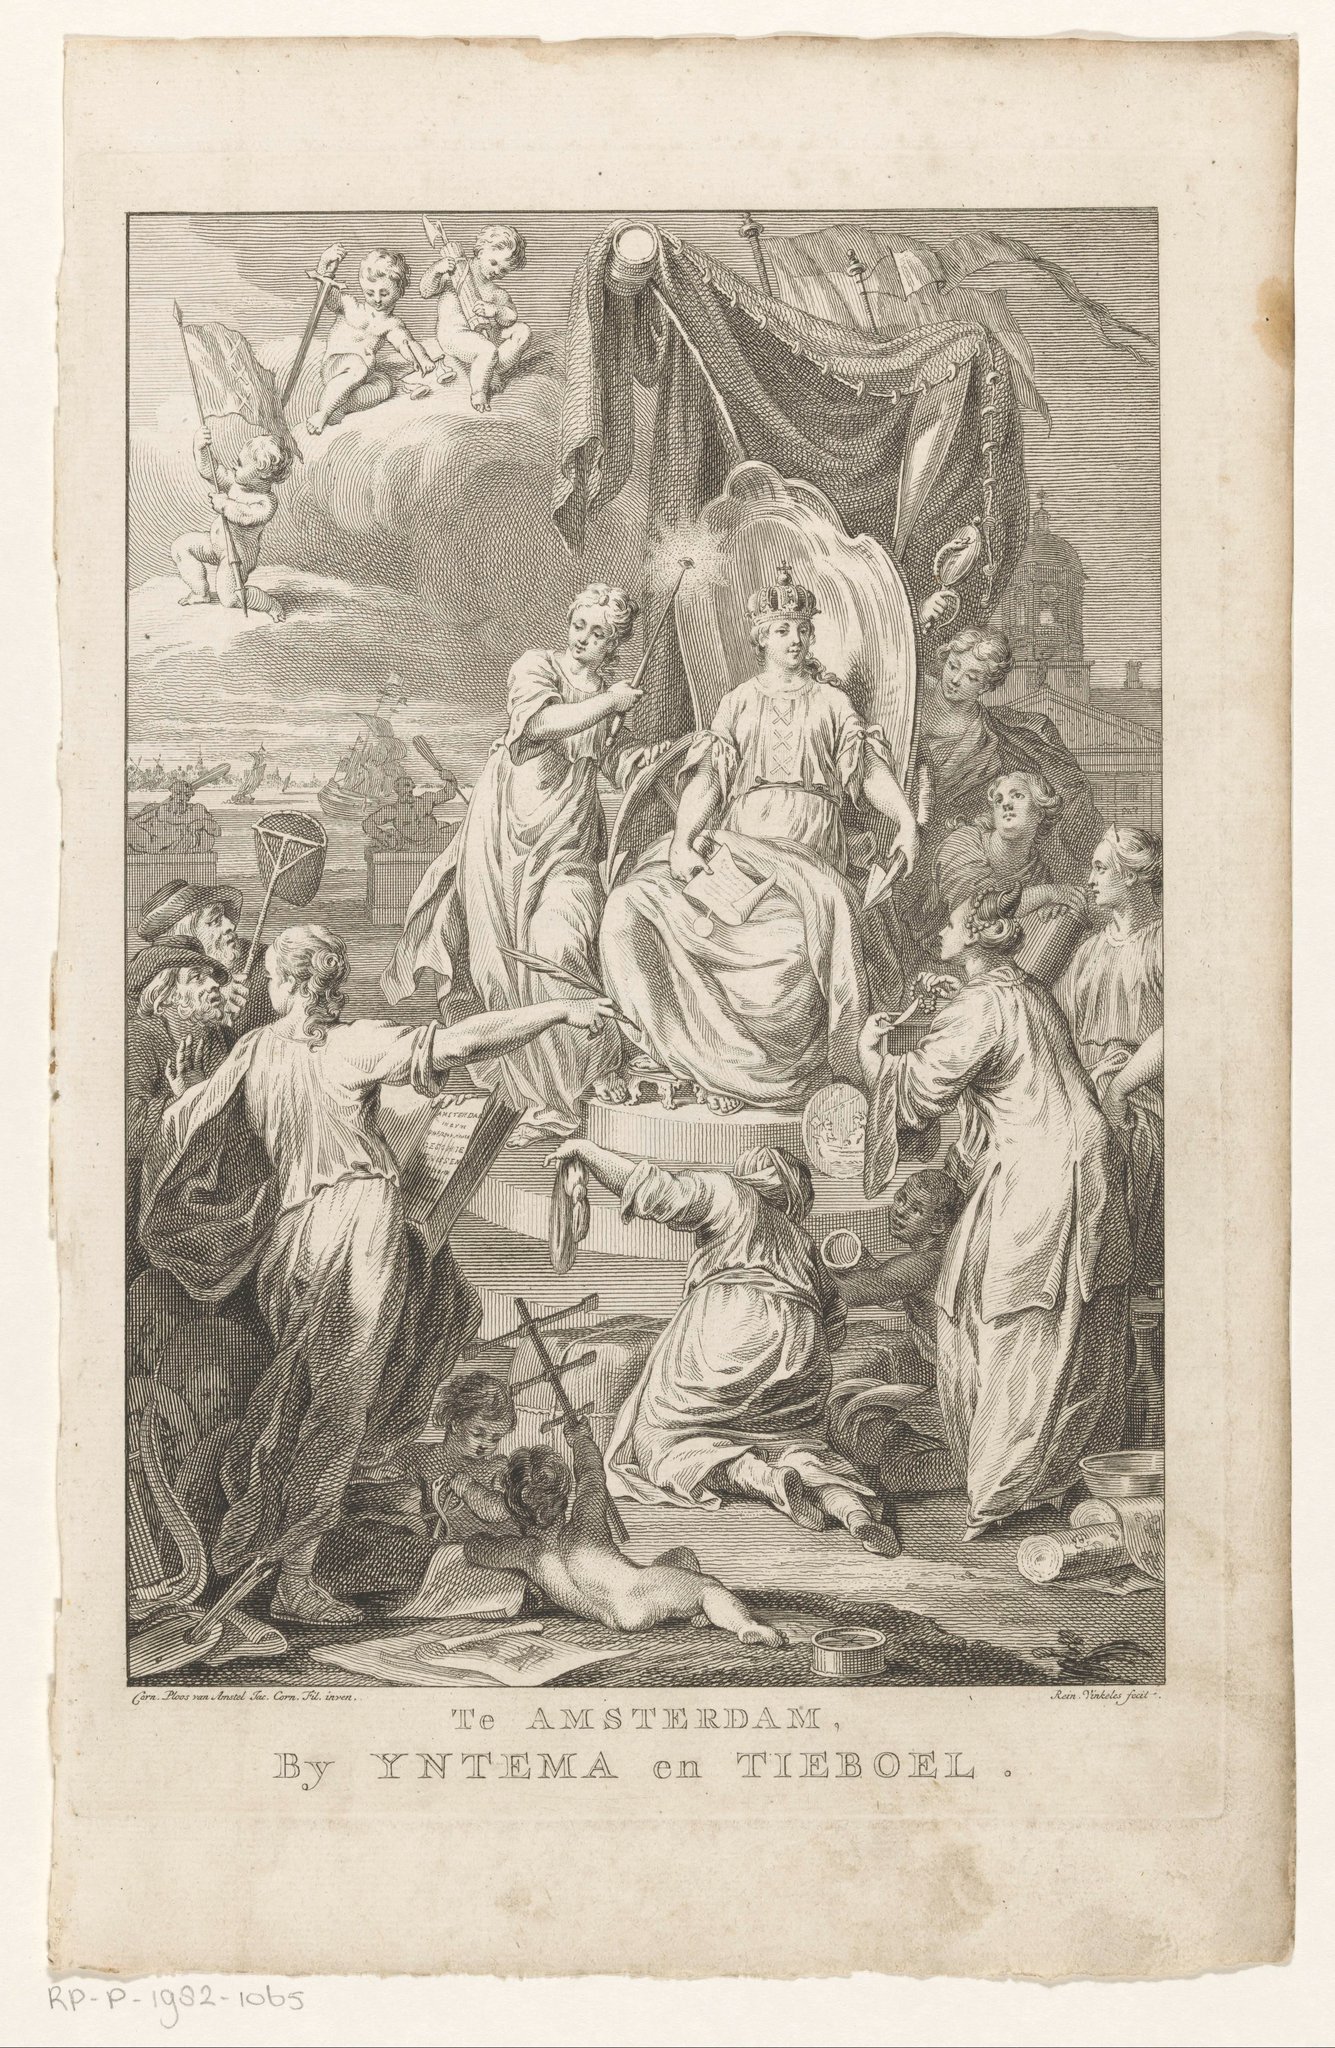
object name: titelblad, titelpagina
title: Allegorische voorstelling met de Amsterdamse stedenmaagd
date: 1767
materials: paper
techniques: engraving, etching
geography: amsterdam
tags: prudence, 'prudentia'; 'prudenza' (ripa) ~ one of the four cardinal virtues, personification of a city, town-patron(ess), 'historia'; 'historia' (ripa), amsterdam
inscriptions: collector's mark: Lugt 2760, collector's mark: Lugt 2228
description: De Amsterdamse gekroonde stedenmaagd zit op een troon, omringd door allegorische figuren. Naast haar staat een vrouwenfiguur met op een staf het Alziend Oog, achter de troon staat Voorzichtigheid met spiegel en slang. Links op de voorgrond Geschiedenis met in haar handen een schrijfveer en een boek. Op de achtergrond het stadhuis op de Dam en beelden van twee riviergoden, de Amstel en het IJ.